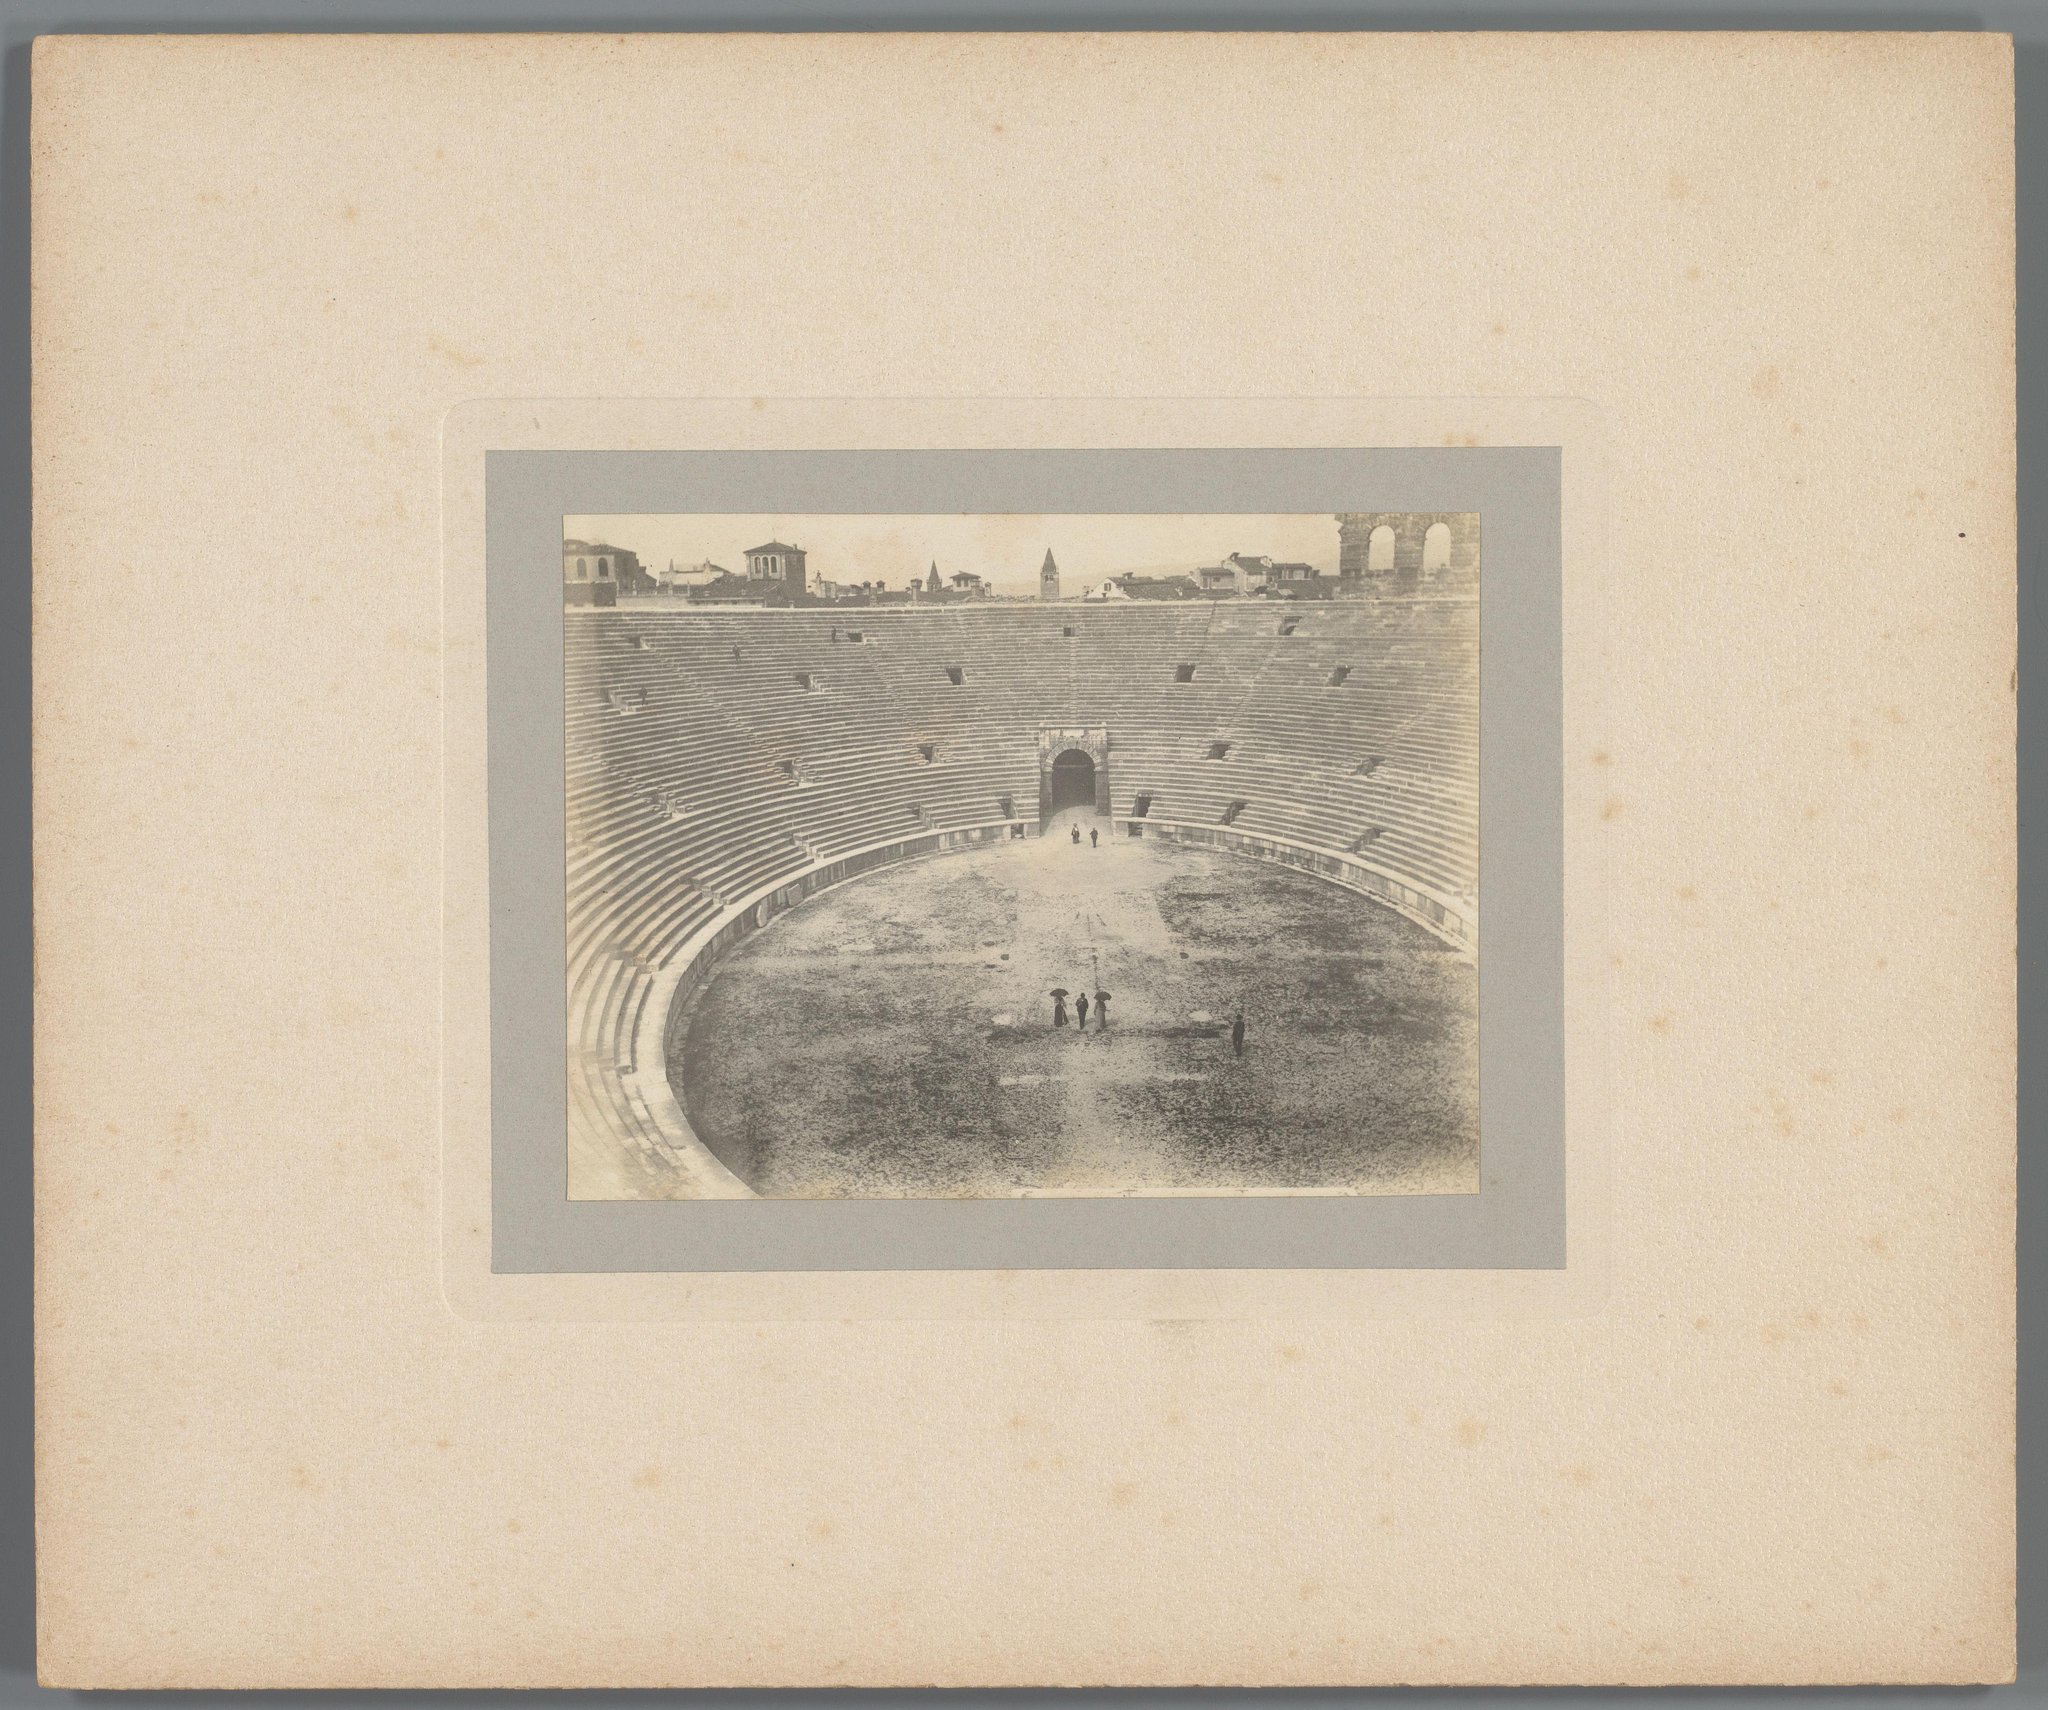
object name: photograph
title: Arena van Verona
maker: françois buys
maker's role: advocaat, amateurfotograaf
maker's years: 1871-1934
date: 1905-1909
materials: paper, cardboard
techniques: gelatin silver print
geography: verona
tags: amphitheatre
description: Deze foto maakt deel uit van een groep van 38 foto's.